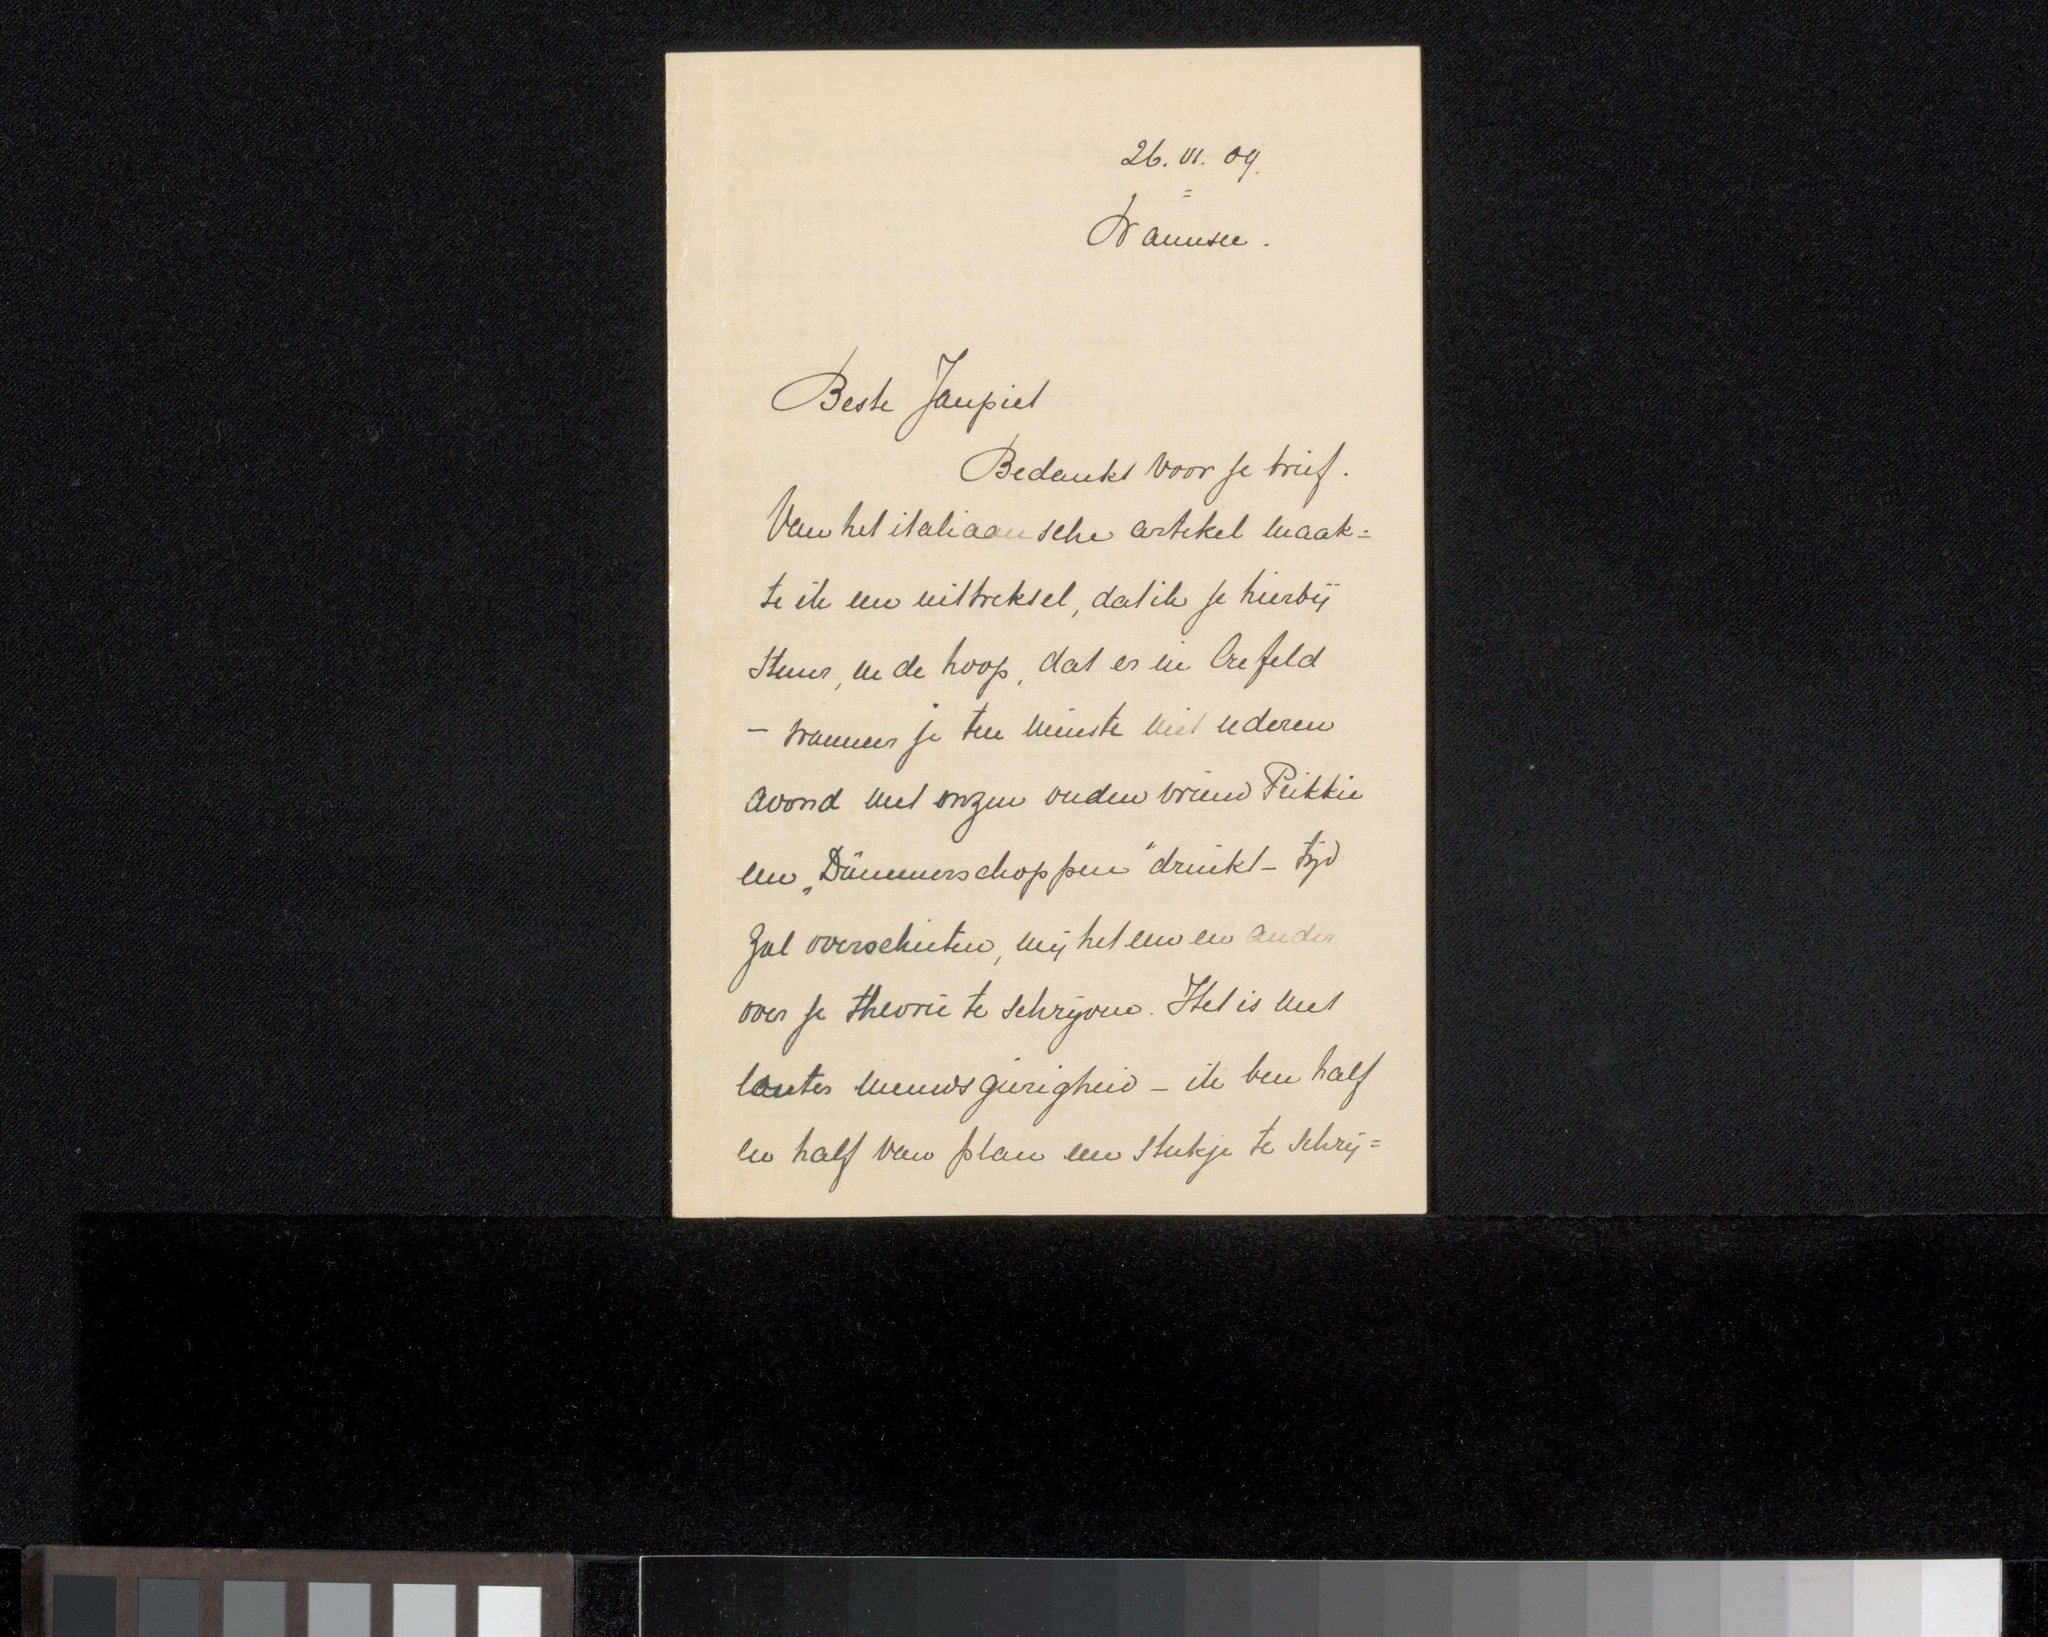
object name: letter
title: Brief aan Jan Veth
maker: andré jolles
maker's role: journalist, kunsthistoricus, letterkundige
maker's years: 1874-1946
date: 1909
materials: ink, paper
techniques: pen, writing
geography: wannsee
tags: dordrecht, designer, jan veth, cologne, johan thorn prikker, leiden, painter, print maker, draughtsman, rembrandt van rijn, jan wagenaar, amsterdam, applied arts, arts and crafts; industrial design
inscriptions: collector's mark: ‘RPK’